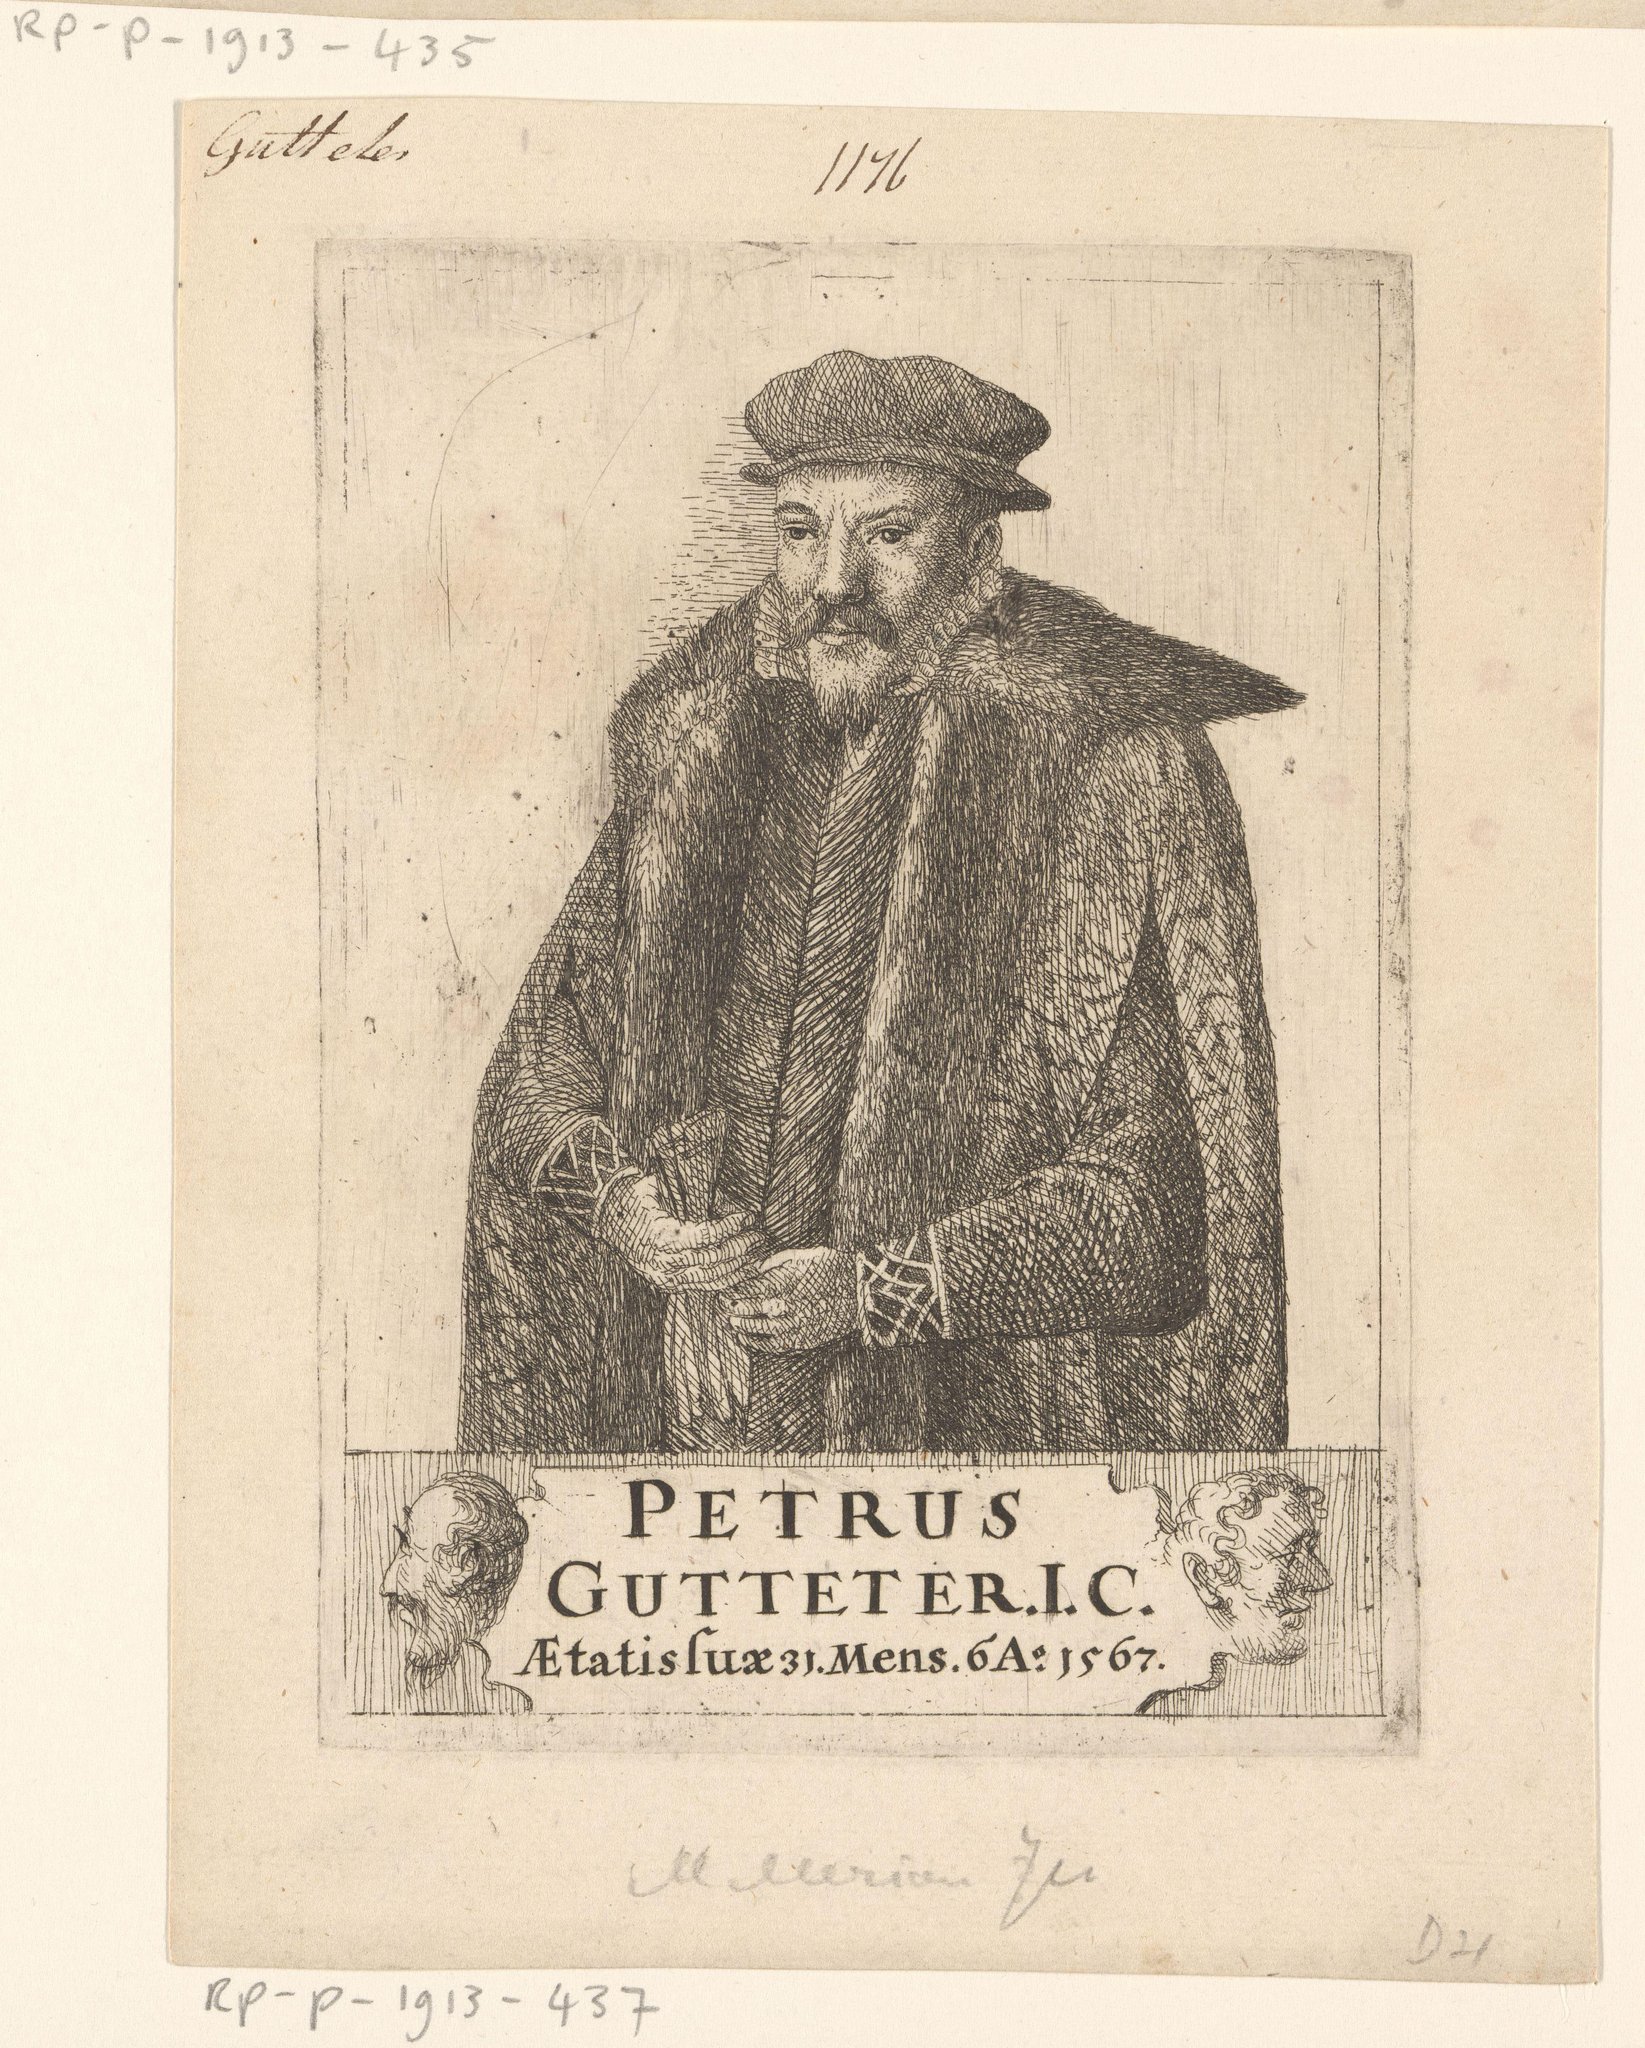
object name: print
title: Portret van Peter Gutthäter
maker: georg thomas gutthäter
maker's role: print maker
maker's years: 1654-1695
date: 1664-1695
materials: paper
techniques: engraving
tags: germany, ornament ~ human parts, gloves, mittens, etc., historical persons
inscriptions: collector's mark: Lugt 2228